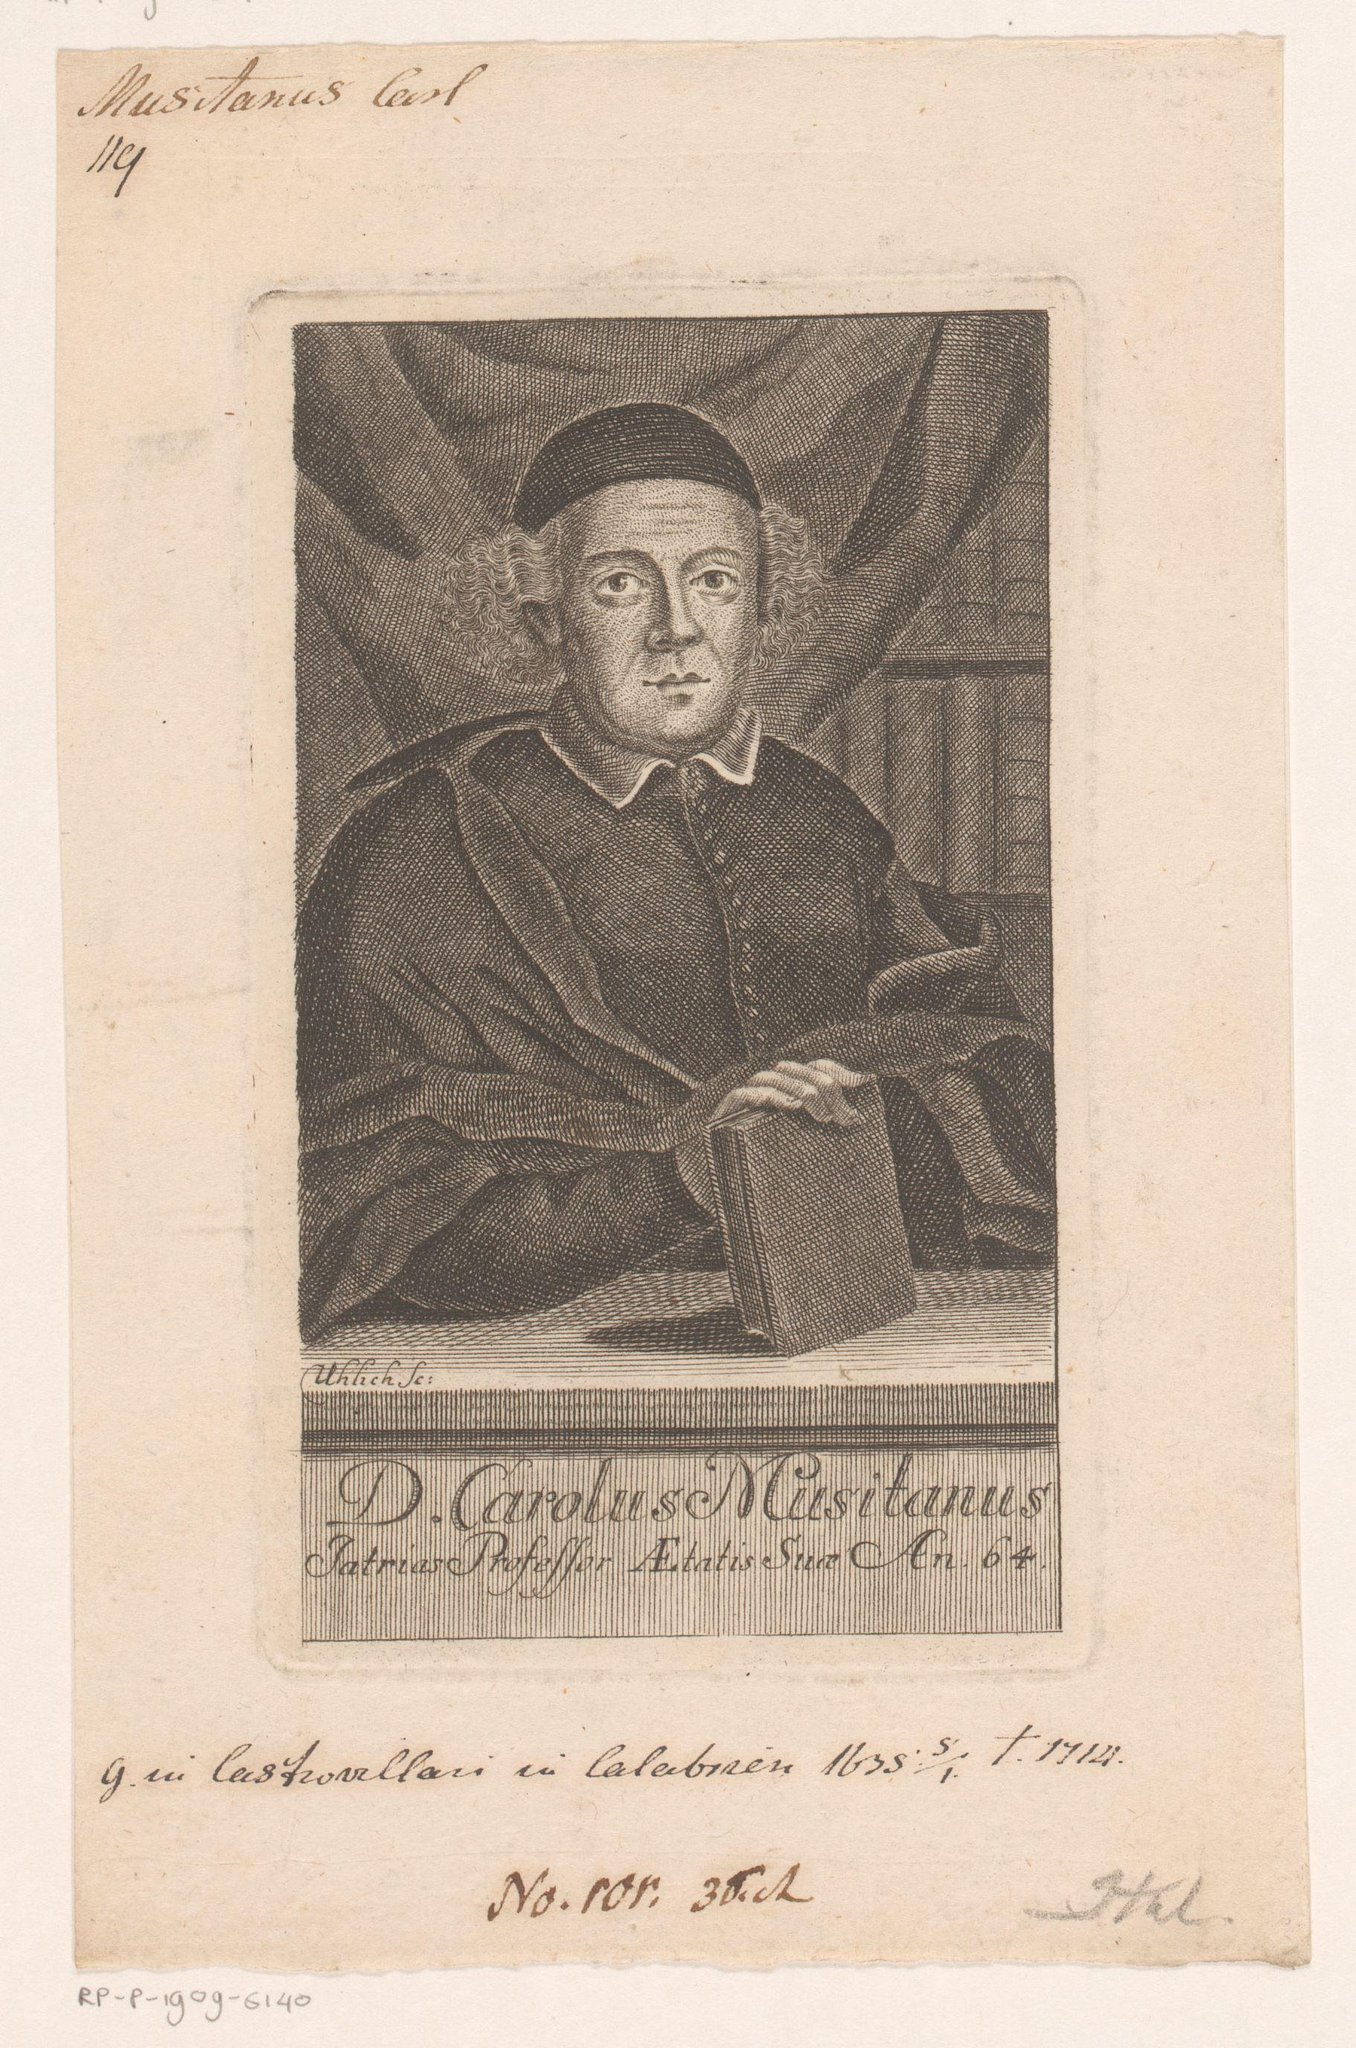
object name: print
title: Portret van Carlo Musitano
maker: gabriel uhlich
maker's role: print maker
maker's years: 1682-1741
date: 1692-1741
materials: paper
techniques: engraving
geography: germany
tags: castrovillari, naples, clergyman, historical persons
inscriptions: inscription: ‘G. in Castrovillari in Calabrien 1635 5/1 † 1714’, inscription: ‘No. ror. 36[...]’, inscription: ‘Musitanus Carl’, number: ‘119’, collector's mark: Lugt 2228